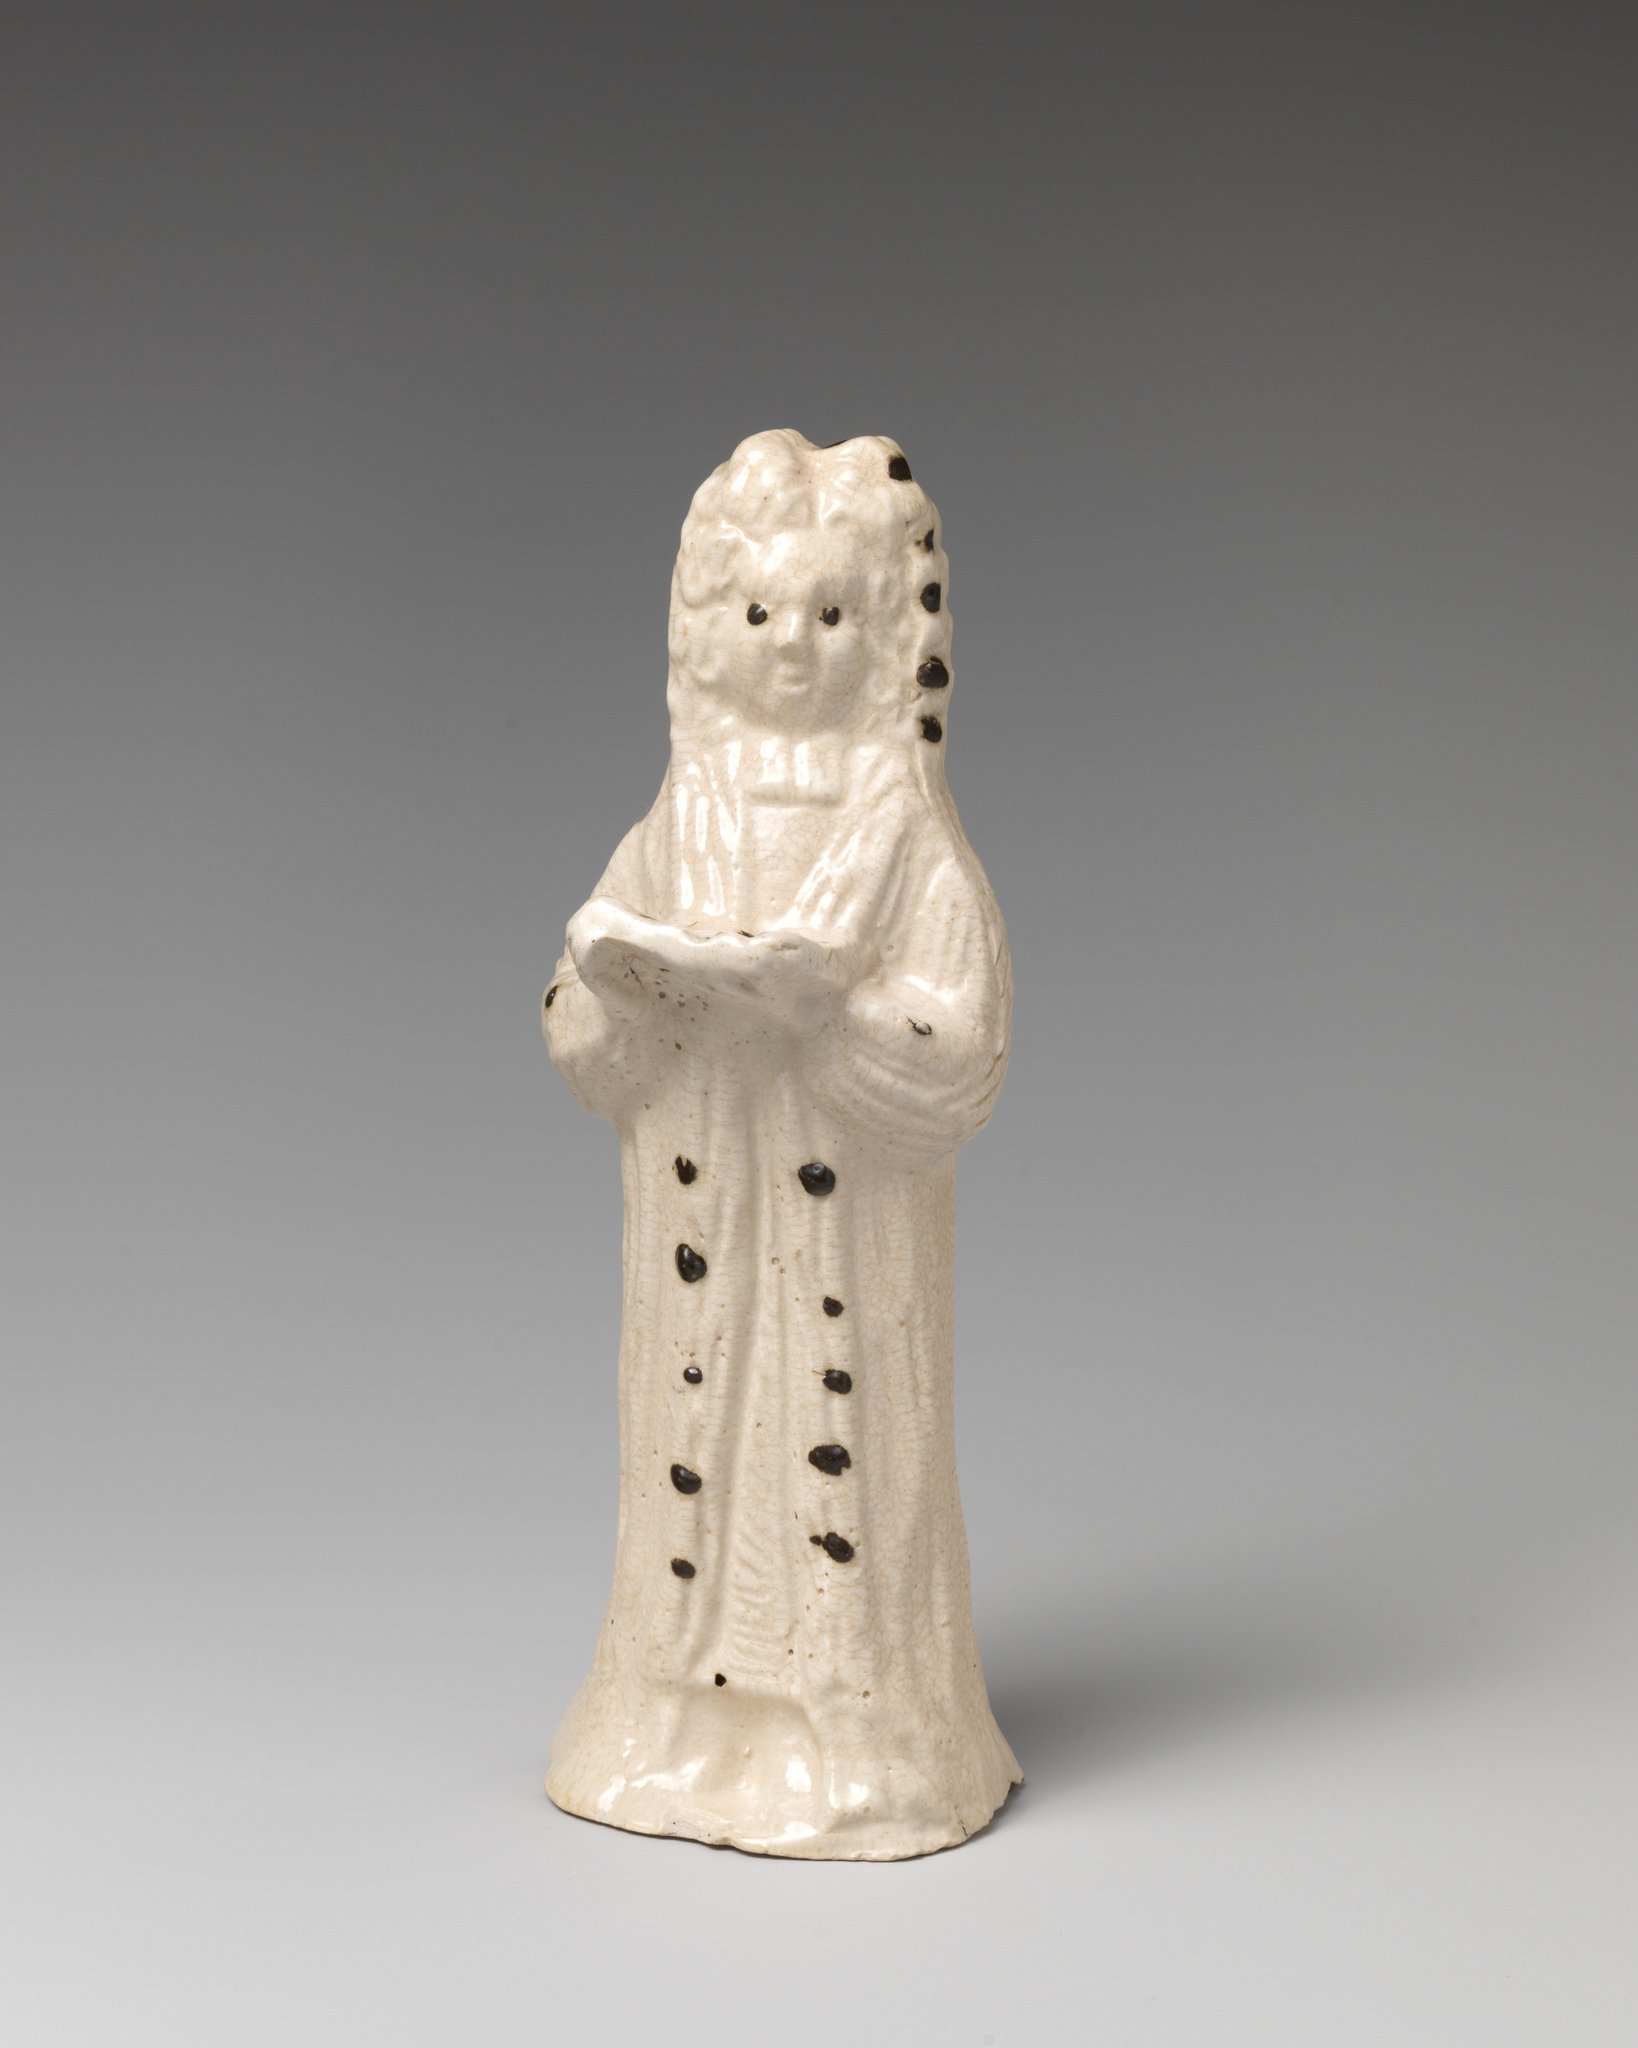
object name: figure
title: Portrait of Dr. Henry Sacheverell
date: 1745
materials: stoneware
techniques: salt glaze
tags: men,portraits